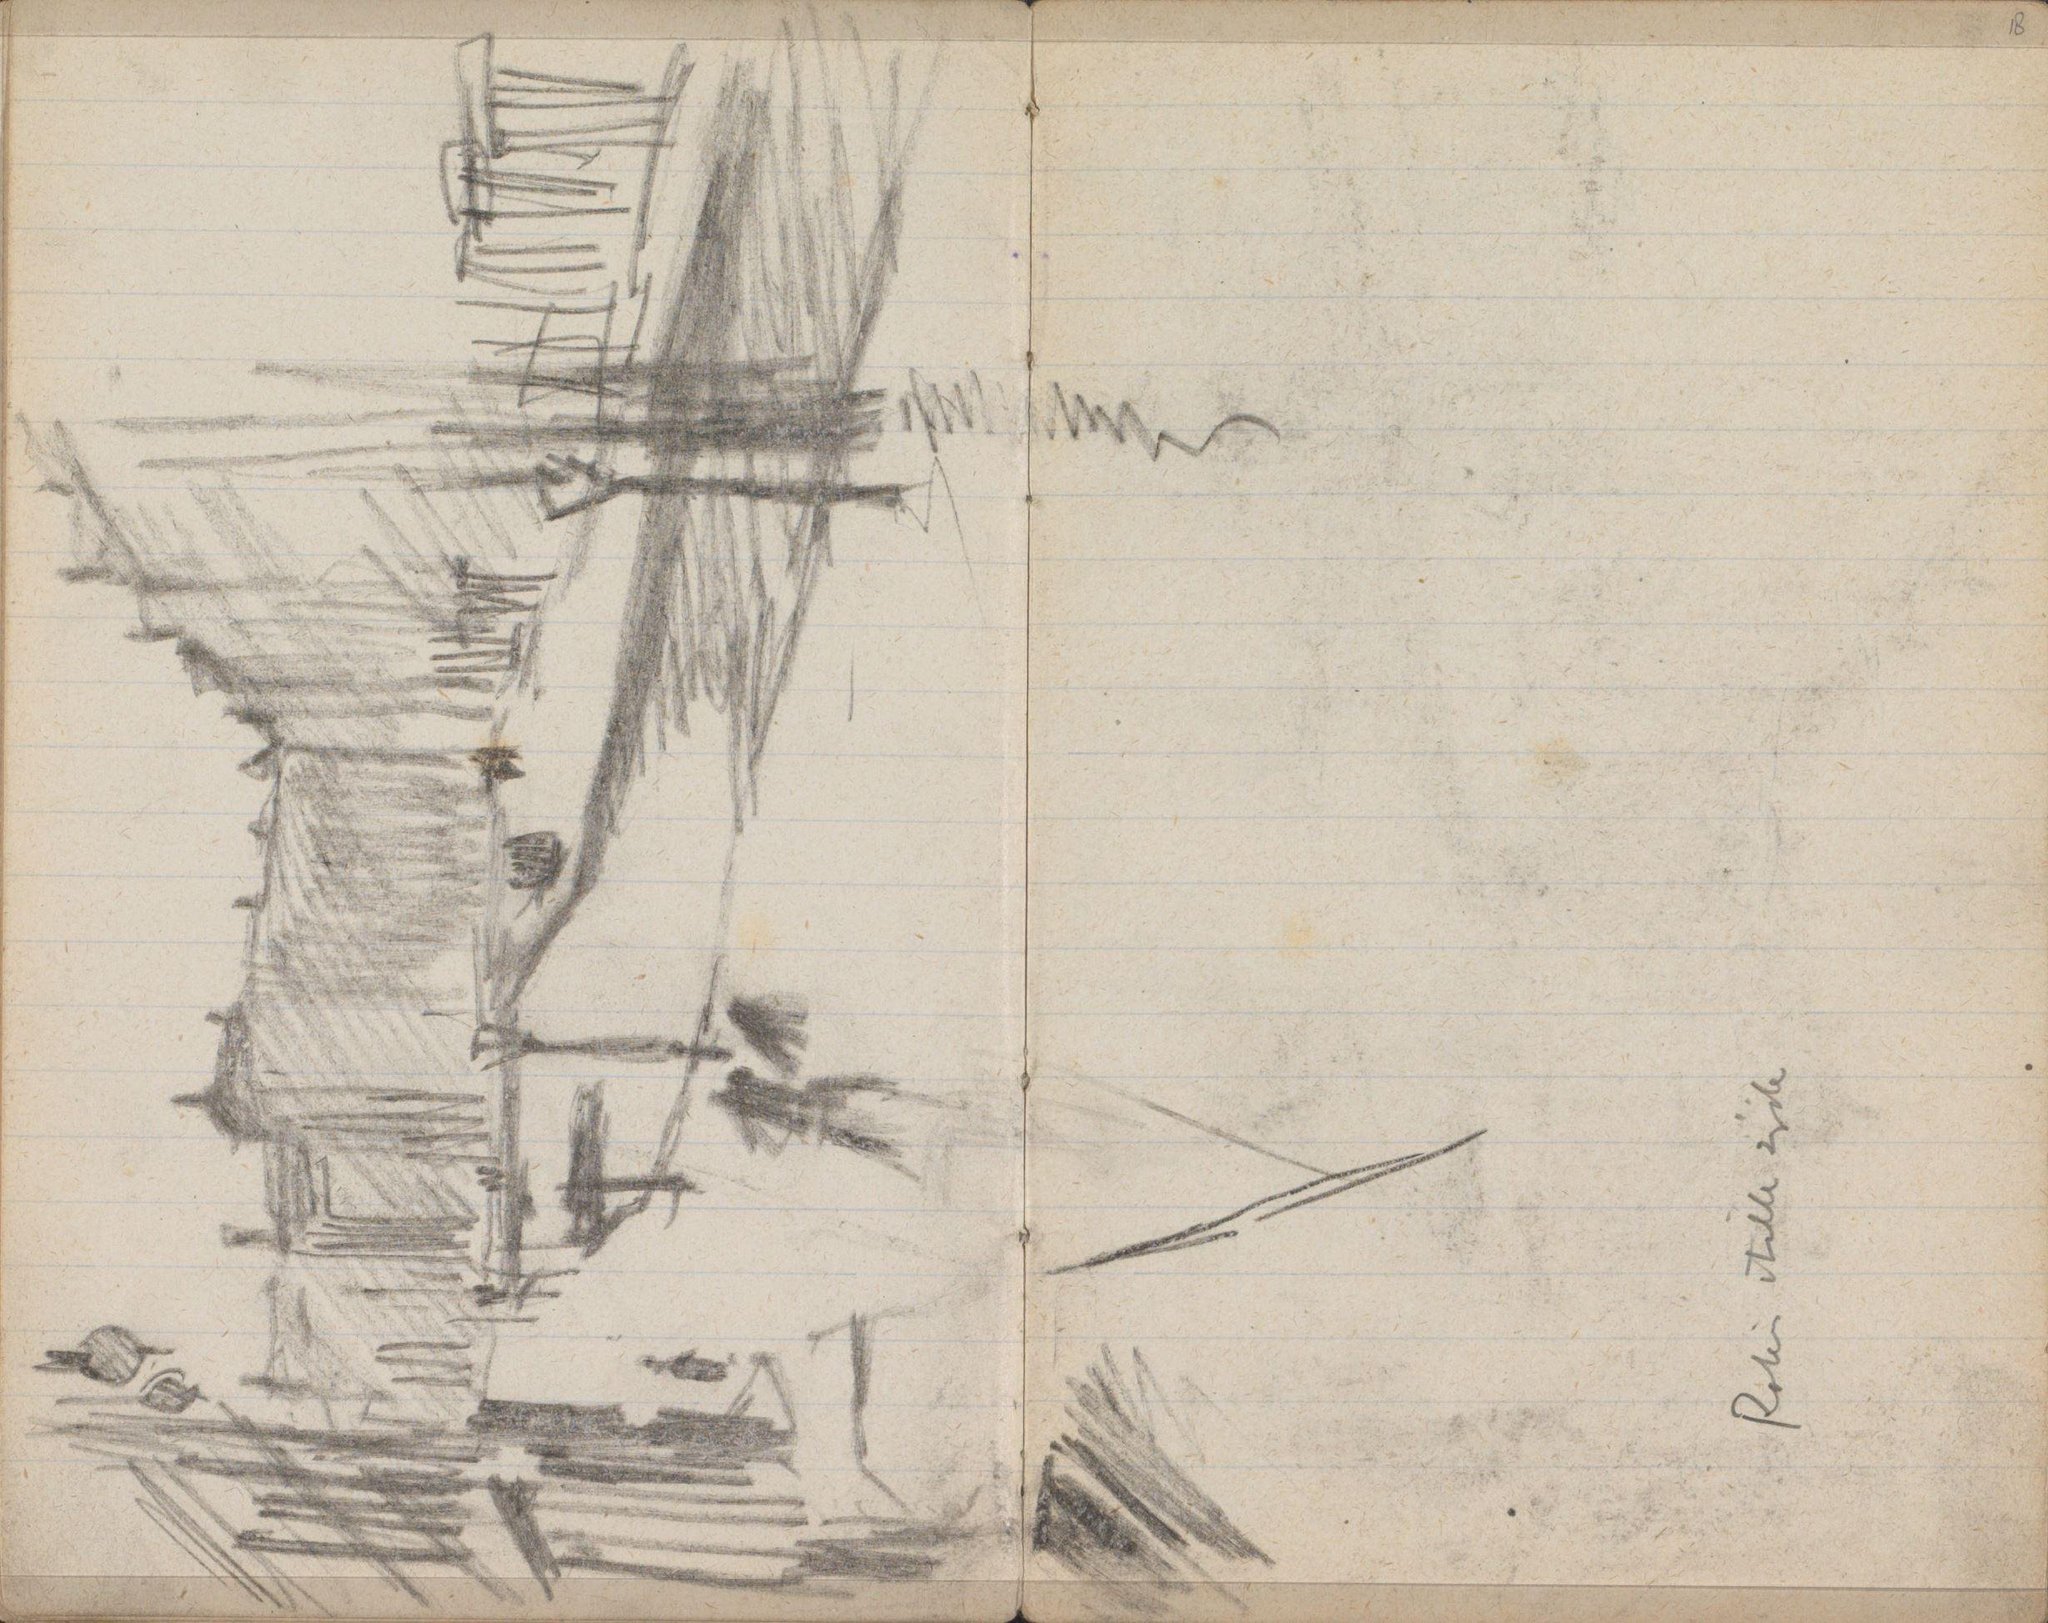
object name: sketchbook leaf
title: Gezicht op het Rokin te Amsterdam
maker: george hendrik breitner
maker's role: draughtsman, painter, print maker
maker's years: 1857-1923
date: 1893-1898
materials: chalk, paper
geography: amsterdam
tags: civic architecture; edifices; dwellings, canals, waters (in city) (+ city(-scape) with figures, staffage)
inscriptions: annotation: ‘Rokin stille zijde’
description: Pagina 17 en pagina 18 uit een schetsboek met 31 bladen.